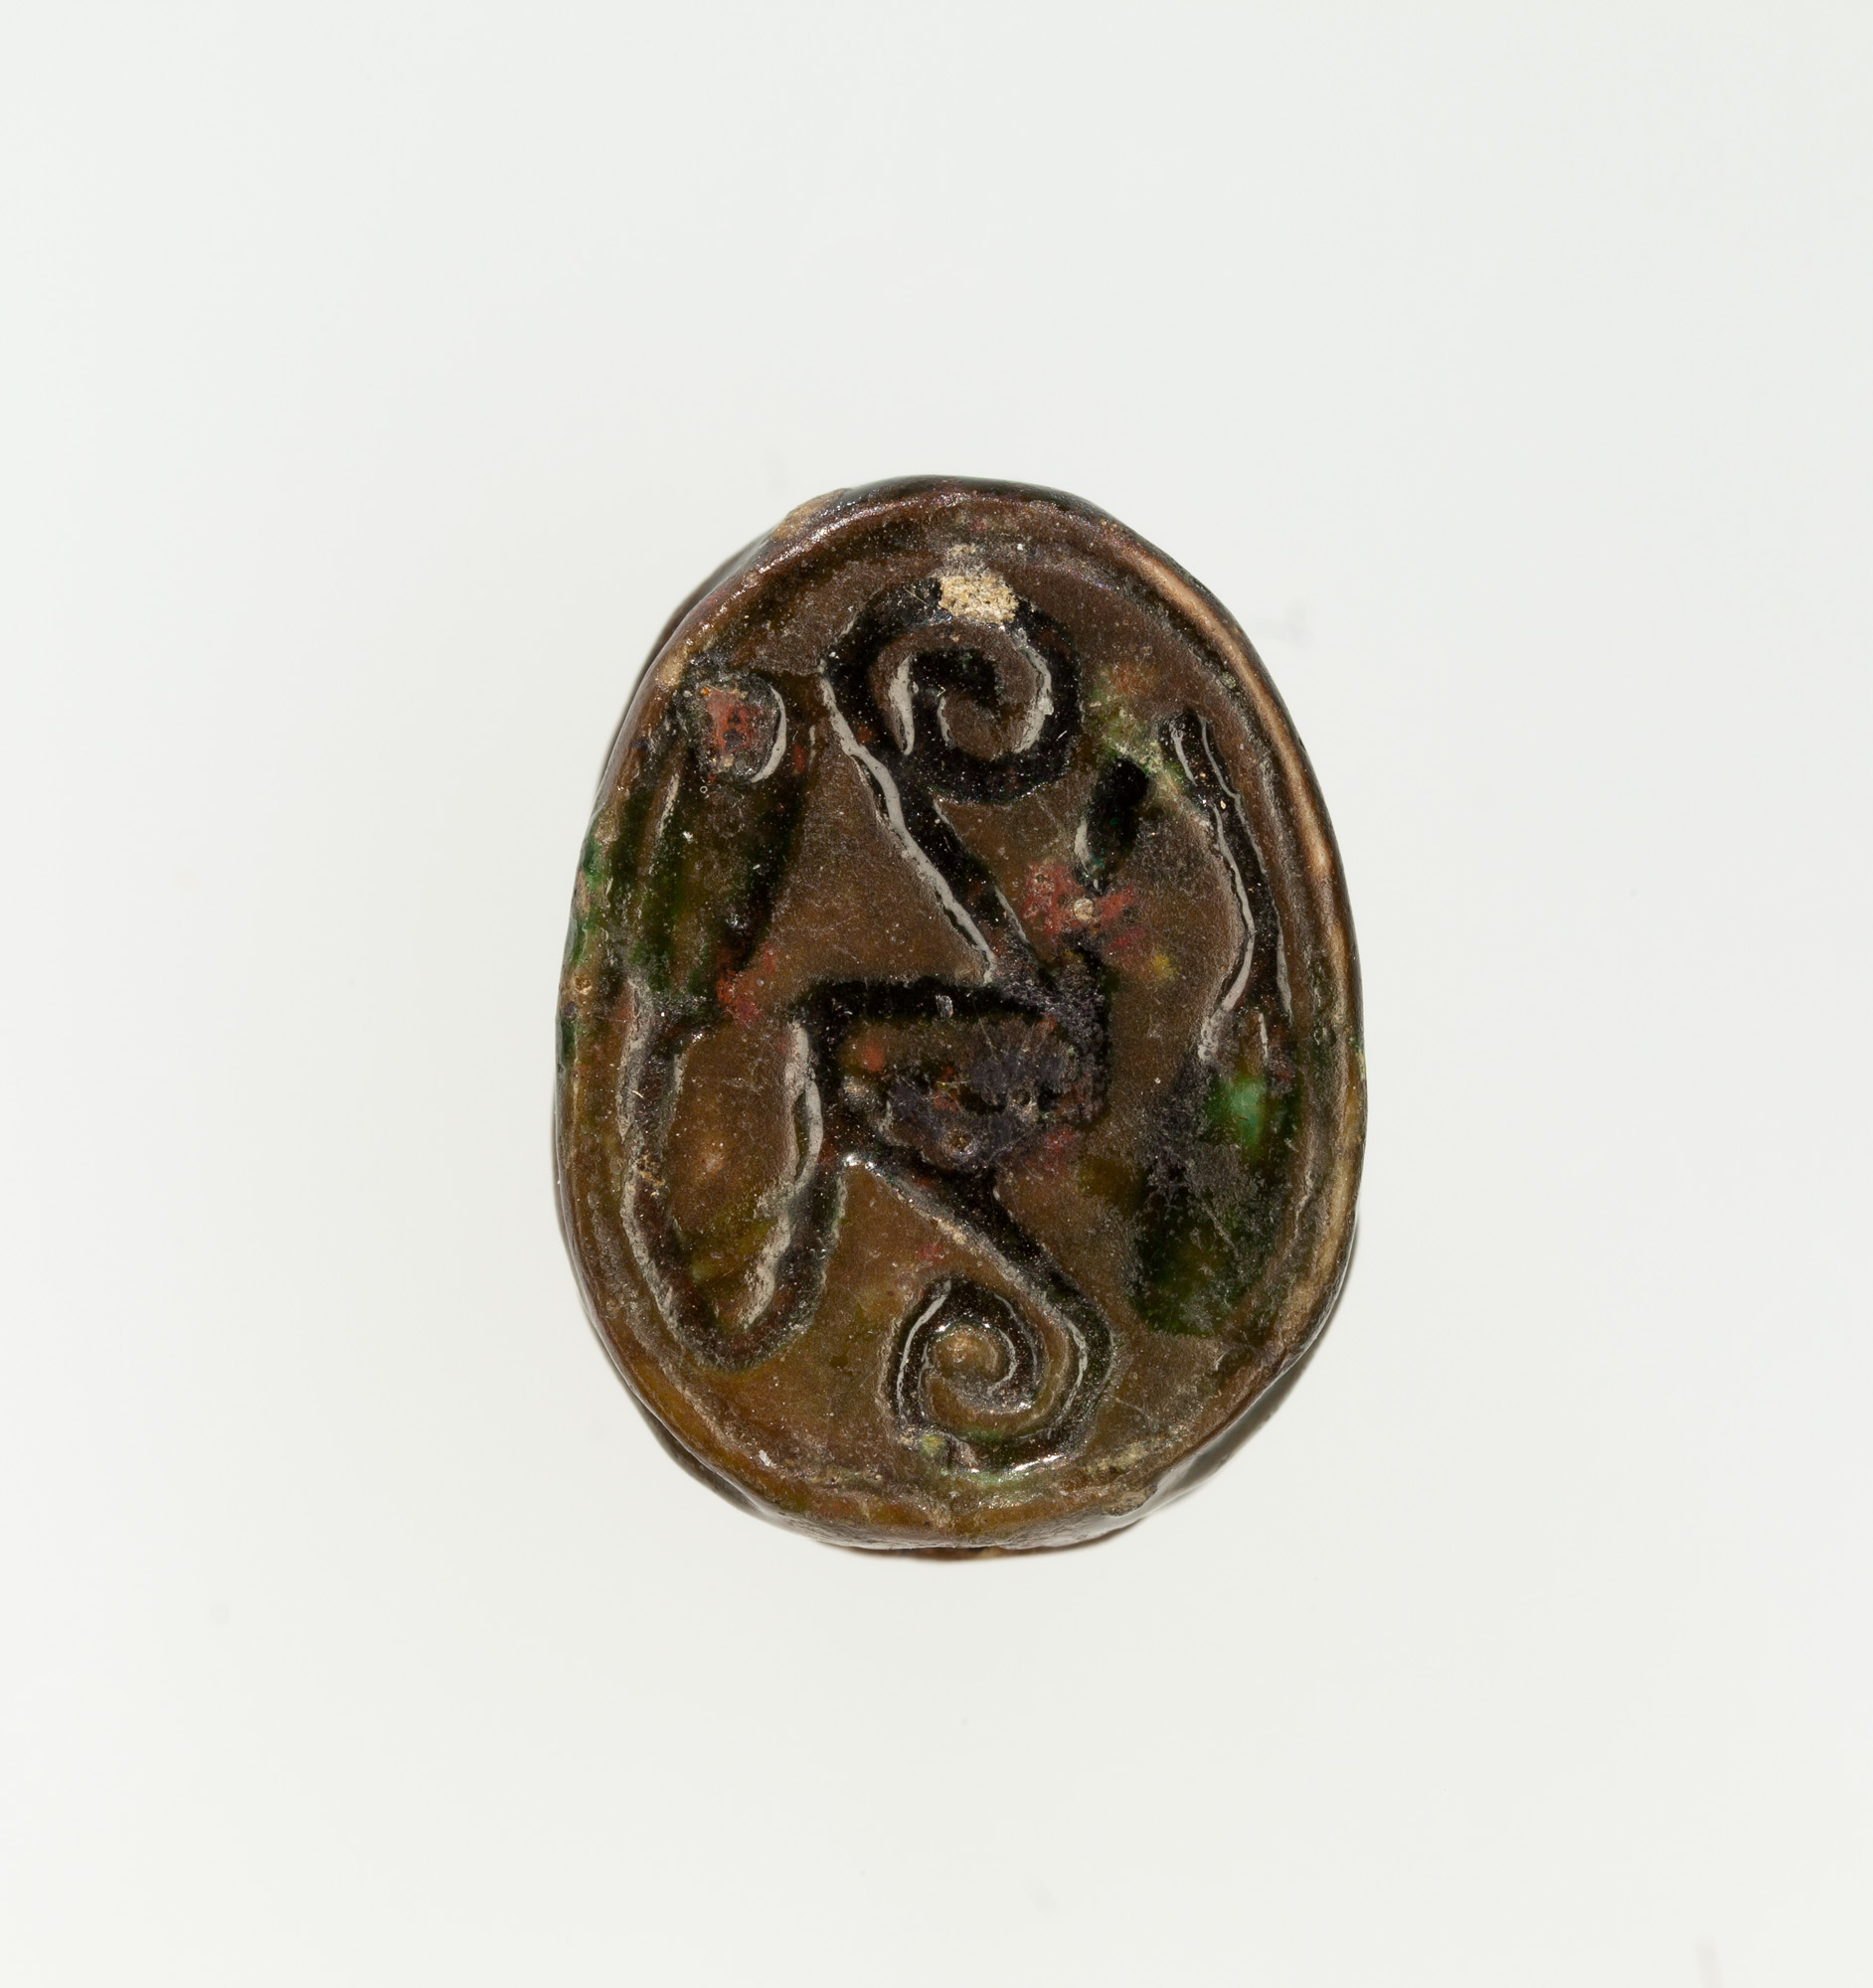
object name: scarab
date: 1479-1458 BCE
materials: faience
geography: egypt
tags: scarabs